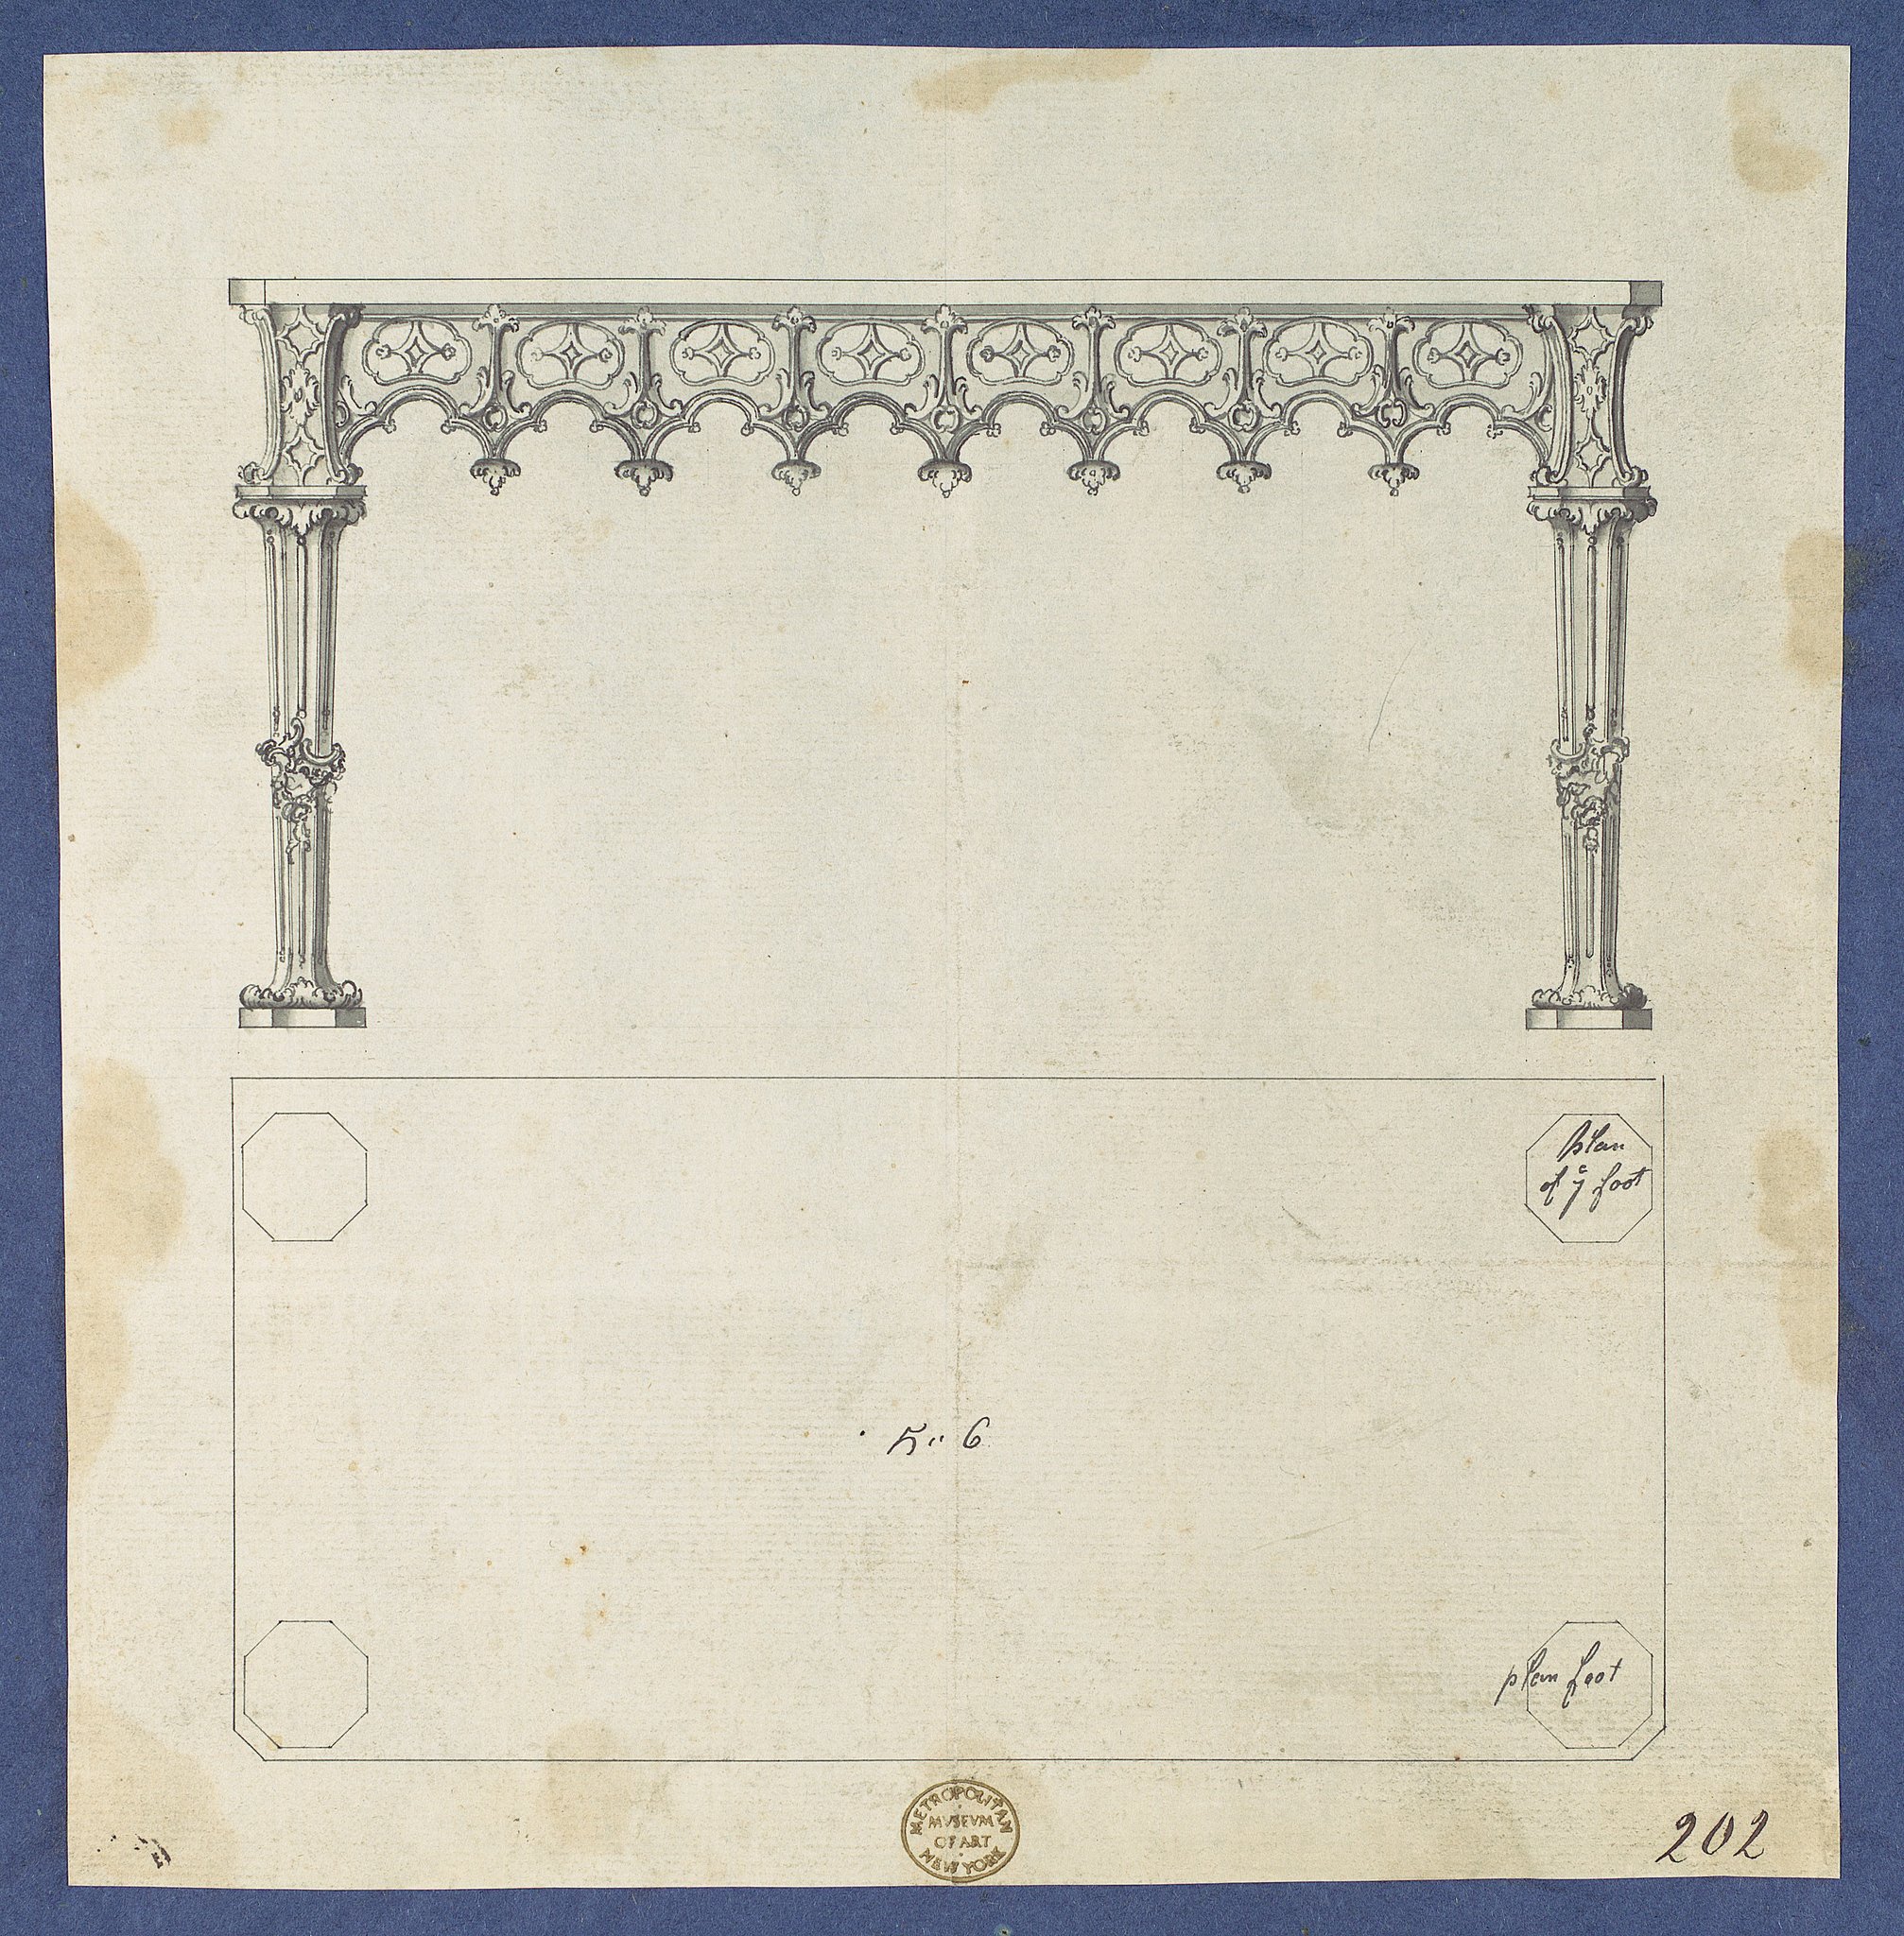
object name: drawing ornament architecture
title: Sideboard Table, from Chippendale Drawings, Vol. II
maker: thomas chippendale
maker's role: artist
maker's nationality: british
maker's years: 1718-1779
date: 1760-1770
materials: ink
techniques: wash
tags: tables